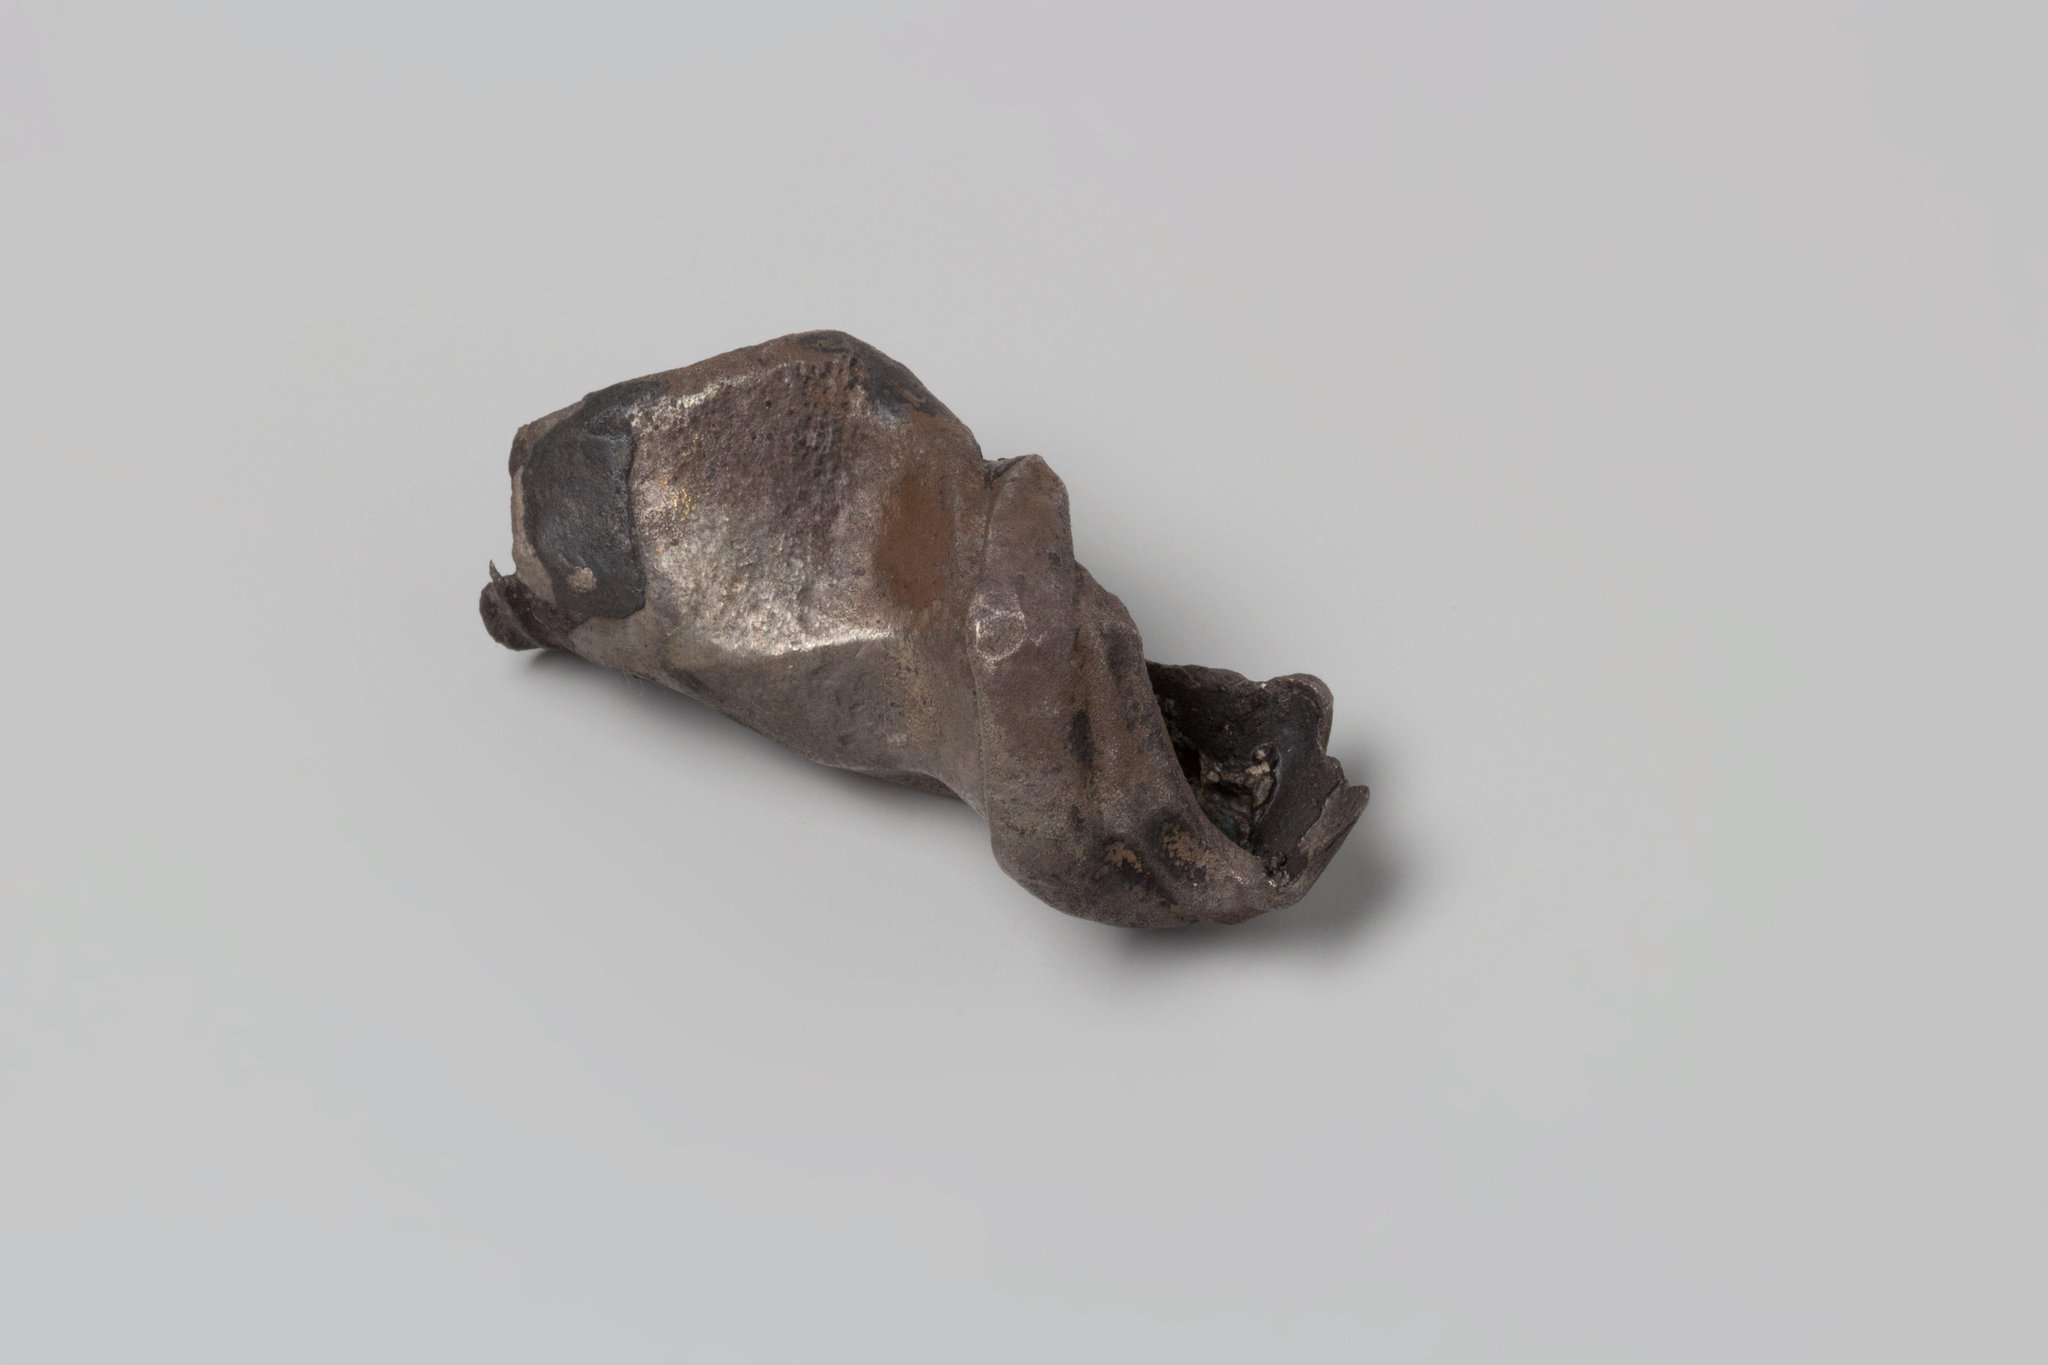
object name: candlestick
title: Fragment steel van een kandelaar uit het wrak van de Oost-Indiëvaarder Hollandia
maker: Anonymous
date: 1700-1743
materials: silver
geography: netherlands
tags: verenigde oostindische compagnie, hollandia (schip), annet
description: Candlestick, stem; fragm of moulded rim, faceted, sim. NG 1980-27H2988.